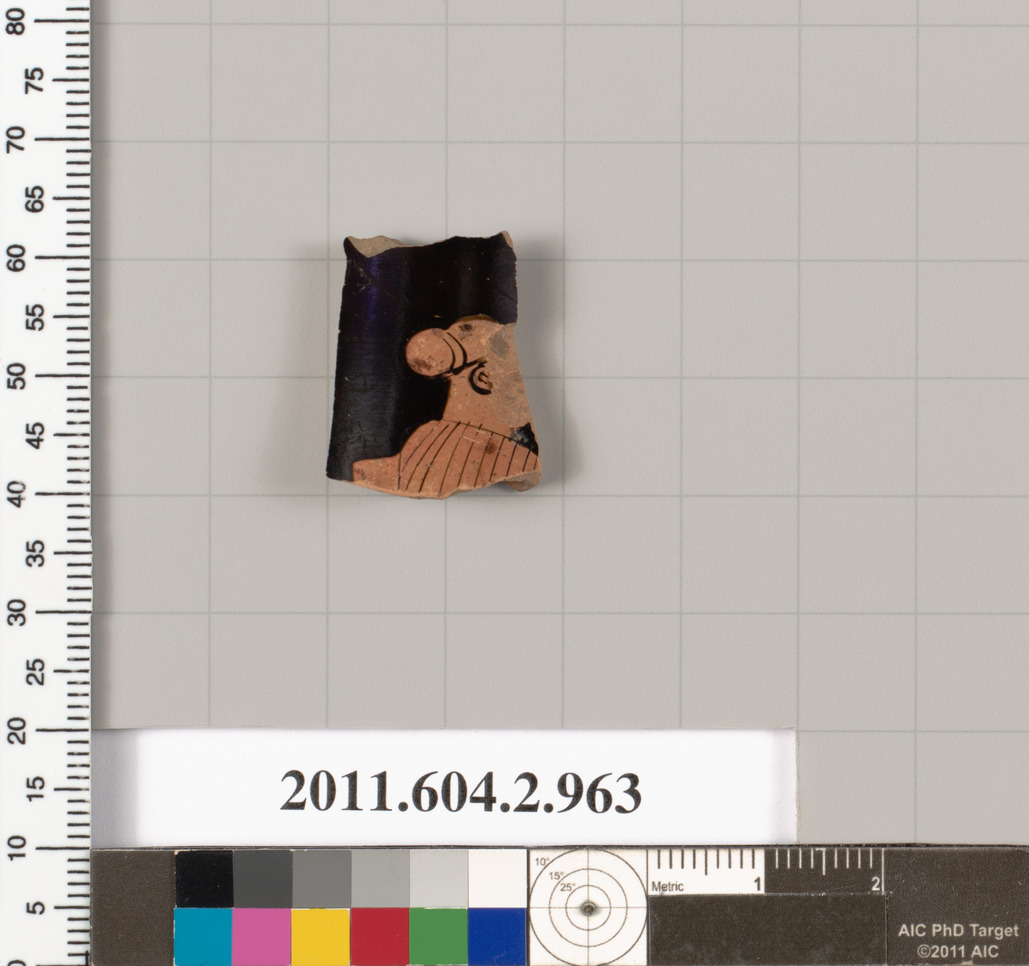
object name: oinochoe fragment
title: Terracotta fragment of an oinochoe (jug)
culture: greek, attic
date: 450-440 BCE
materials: terracotta